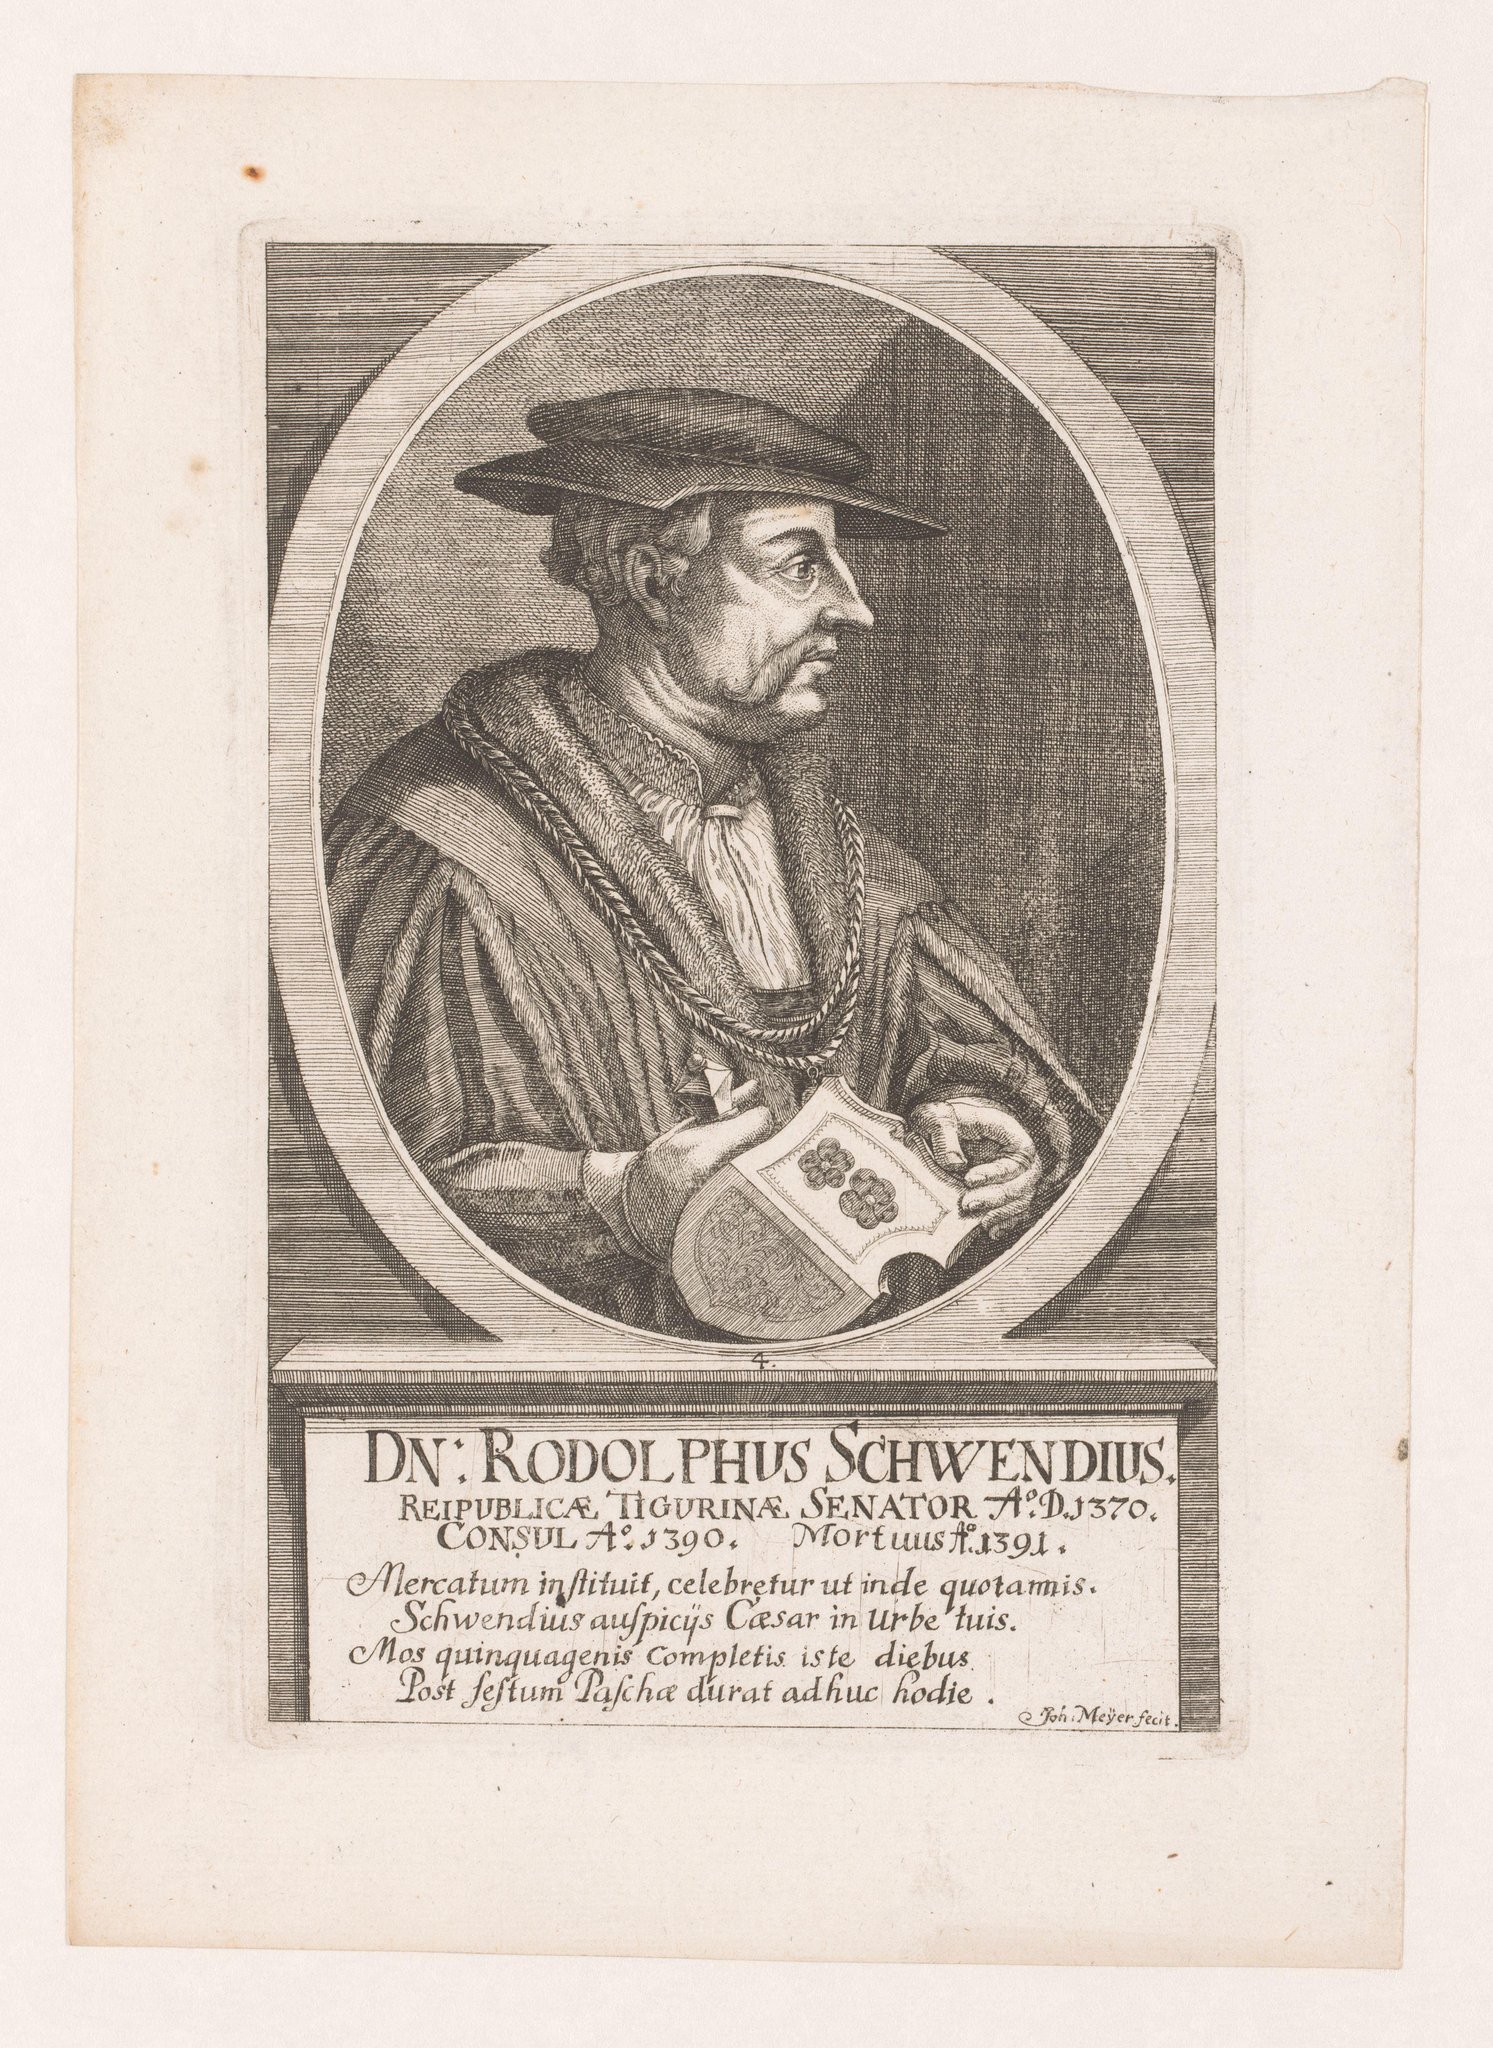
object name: print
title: Portretten van burgemeesters van Zürich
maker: johannes meyer (ii)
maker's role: print maker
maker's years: 1655-1712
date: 1665-1712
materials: paper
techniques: engraving, etching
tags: mayor, mayor, burgomaster, historical persons, armorial bearing, heraldry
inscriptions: collector's mark: Lugt 2228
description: Onderaan de ovale omlijsting genummerd: 4.